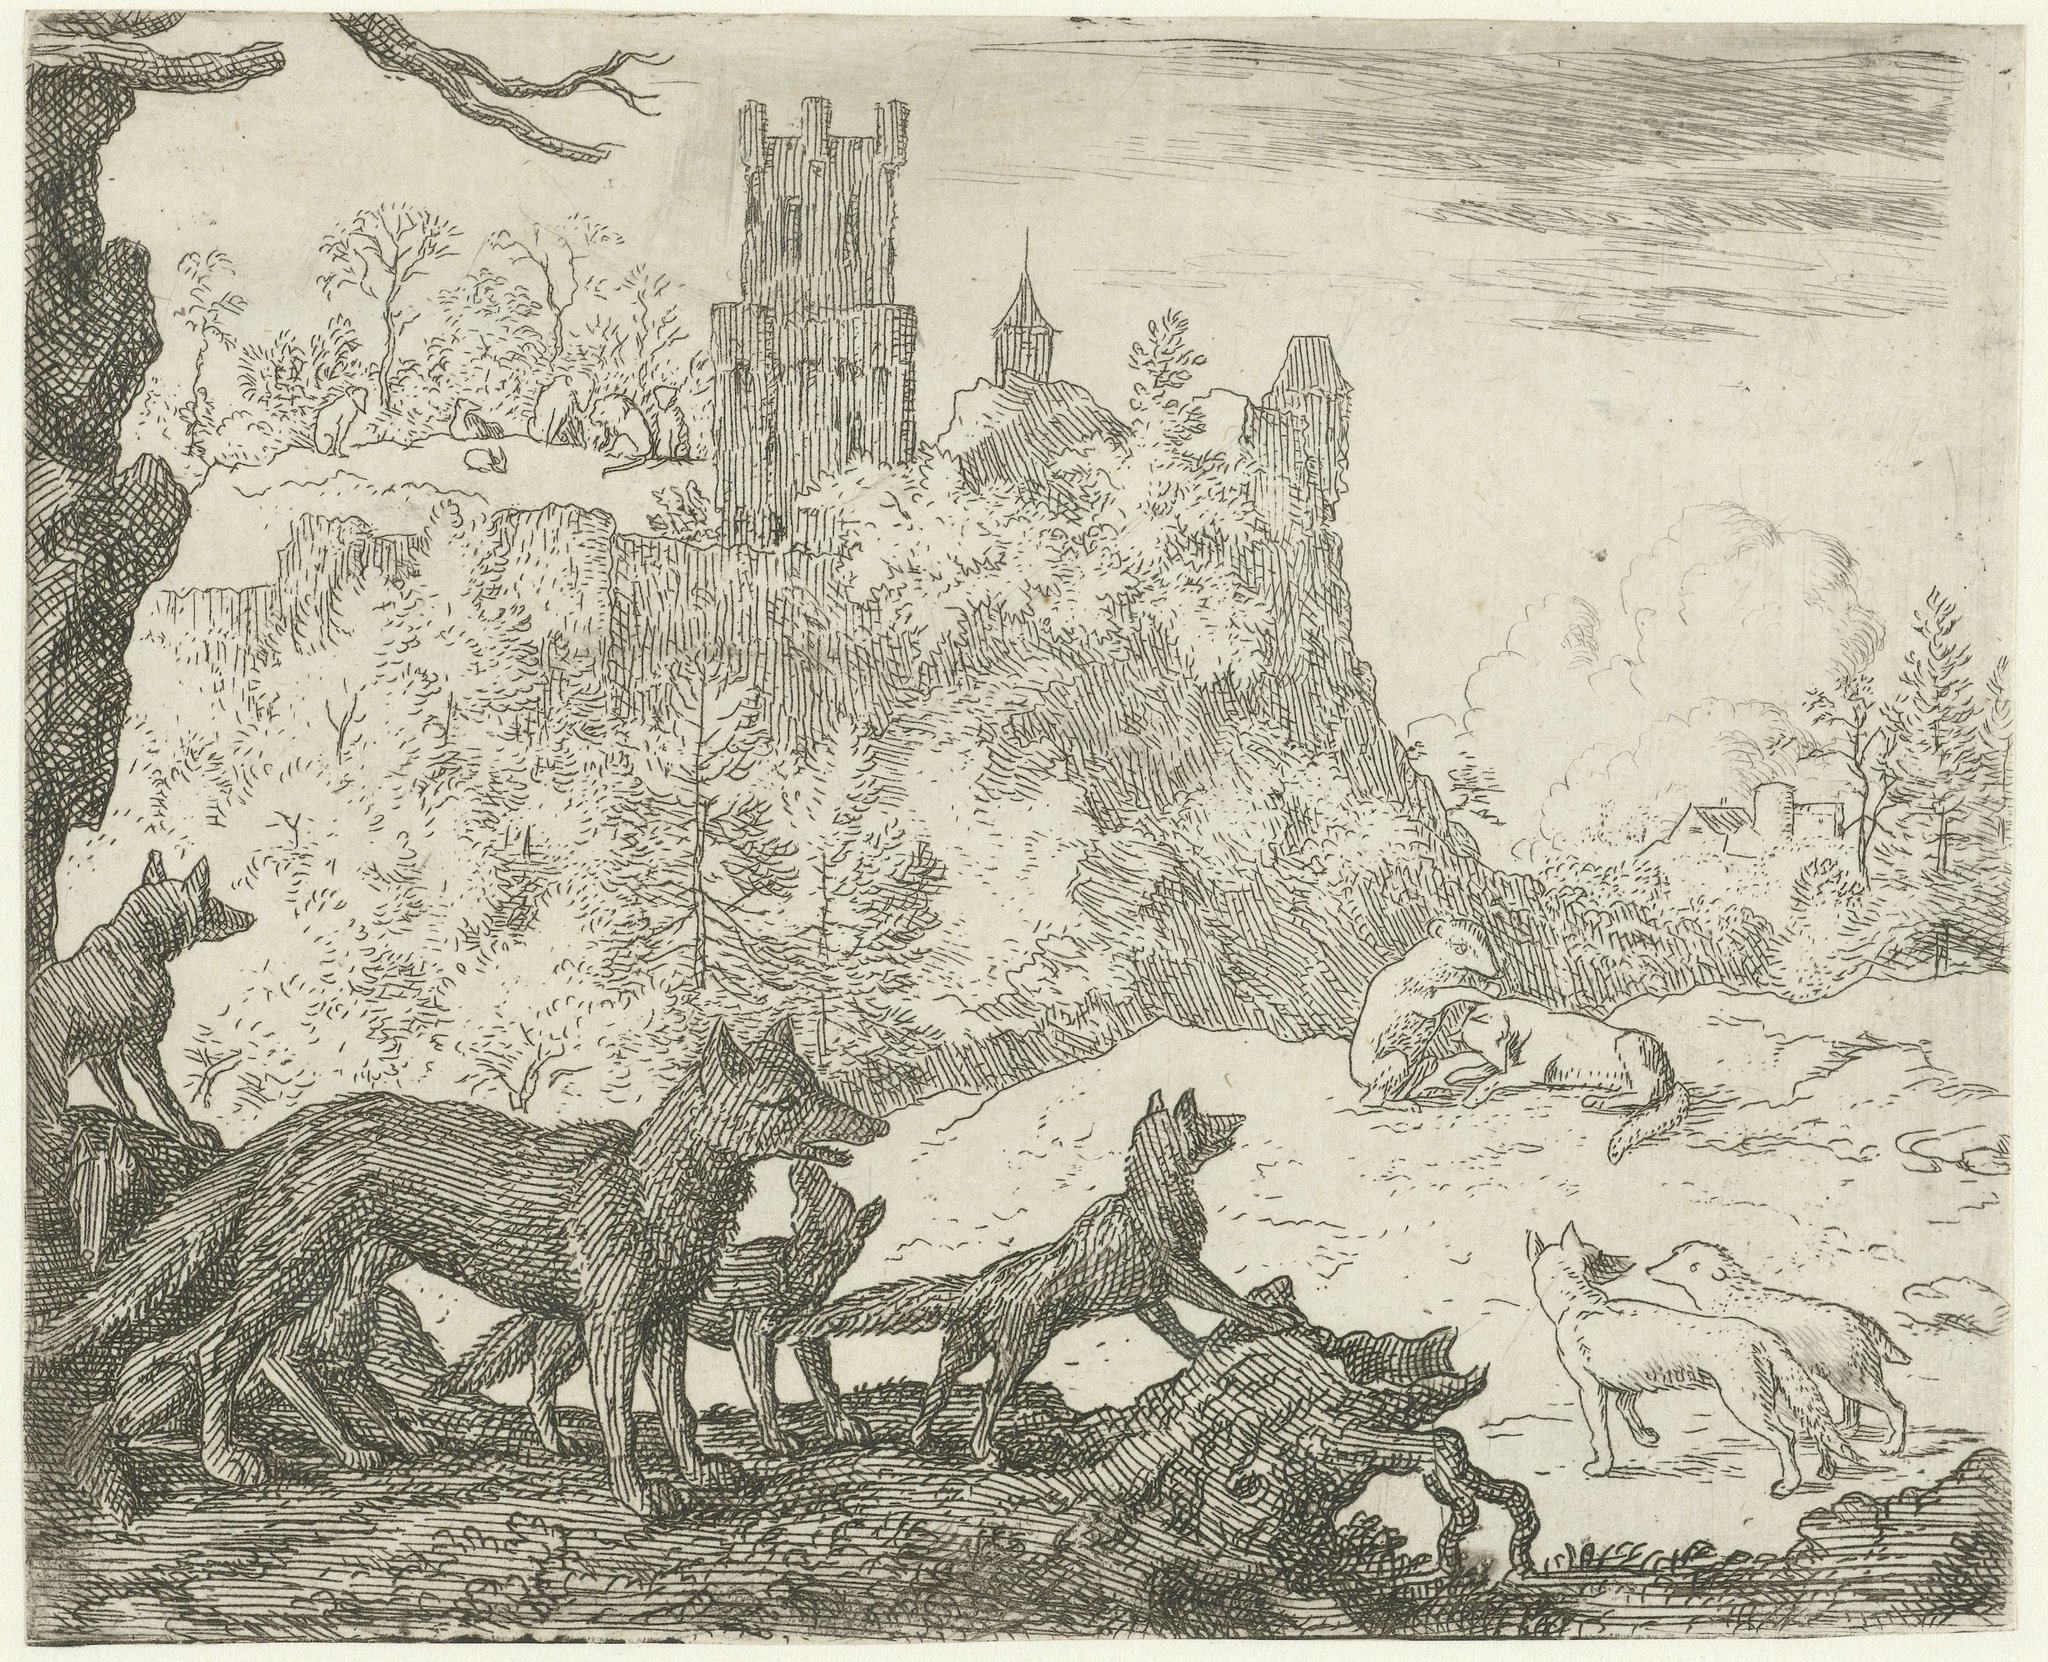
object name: print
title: Reinaert de vos en Grimbeert de das op weg naar het gerecht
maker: allaert van everdingen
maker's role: draughtsman, painter, print maker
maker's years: 1621-1675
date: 1665-1675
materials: paper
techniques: etching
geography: netherlands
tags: fable of reynard the fox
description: Een vrouwtjes vos en haar drie jongen kijken uit over de vallei waar Reinaert de vos en Grimbeert de das samen op weg zijn naar het gerecht.